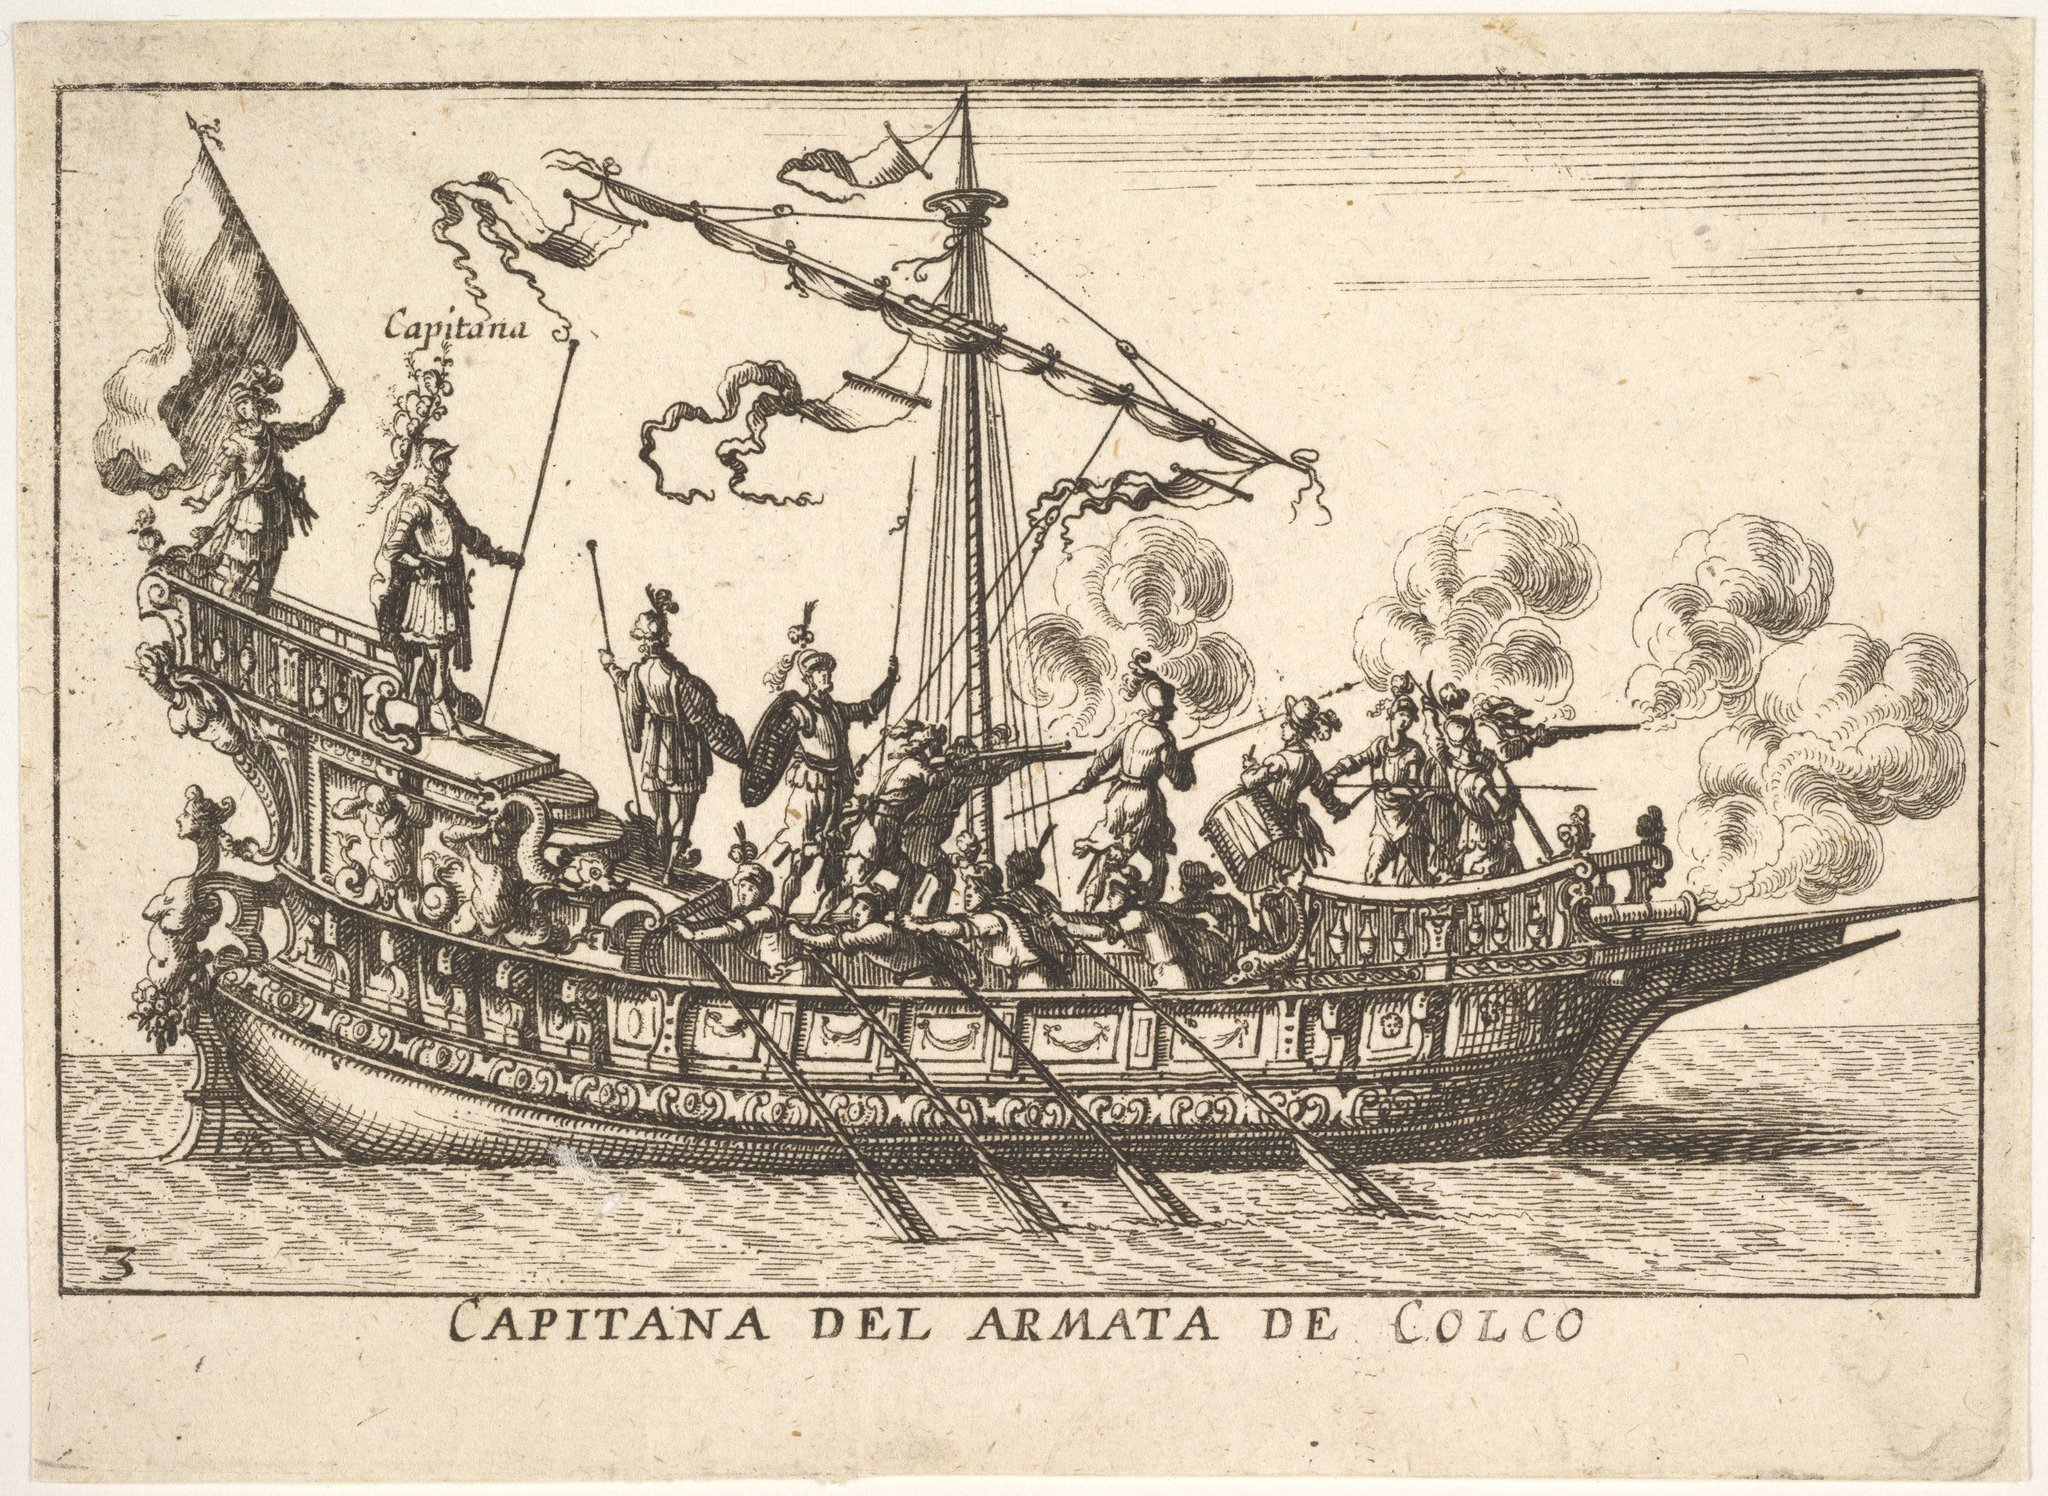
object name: print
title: Plate 3: Captain of the army of Chalchis (Capitana del armata de Colco), from "The magnificent pageant on the river Arno in Florence for the marriage of the Grand Duke" (Le Magnifique carousel fait sur le fleuve de l'Arne a Florence, pour le mariage du Grand Duc)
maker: Anonymous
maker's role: artist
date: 1664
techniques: etching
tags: army,music,rivers,ships